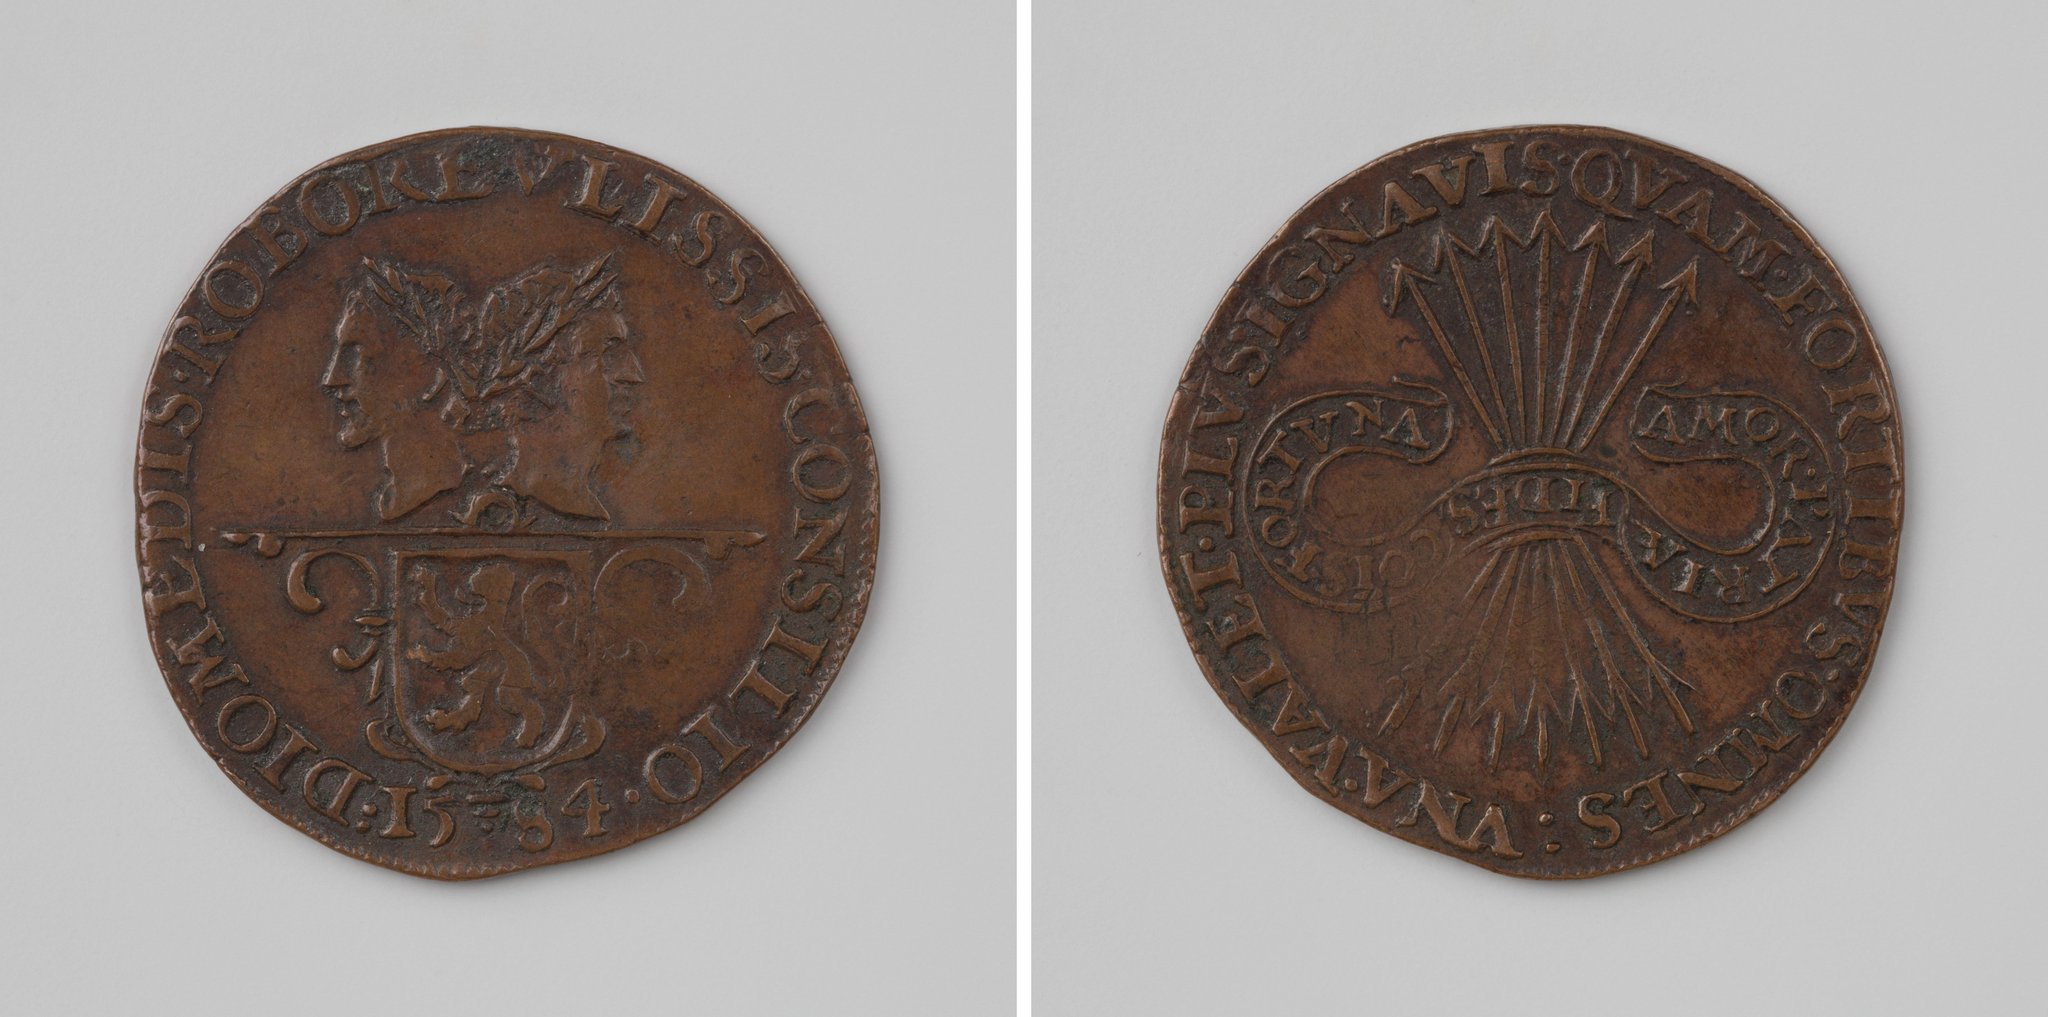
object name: jeton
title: Verdiensten van de vermoorde Willem van Oranje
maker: Anonymous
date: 1584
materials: copper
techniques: striking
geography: netherlands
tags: delft, william i (prince of orange)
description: Koperen penning. Voorzijde: van elkaar afgewende, gelauwerde koppen van Odysseus en Diomedes boven wapenschild binnen omschrift. Keerzijde: bundel van zeven pijlen, omwonden met lint met opschrift binnen omschrift